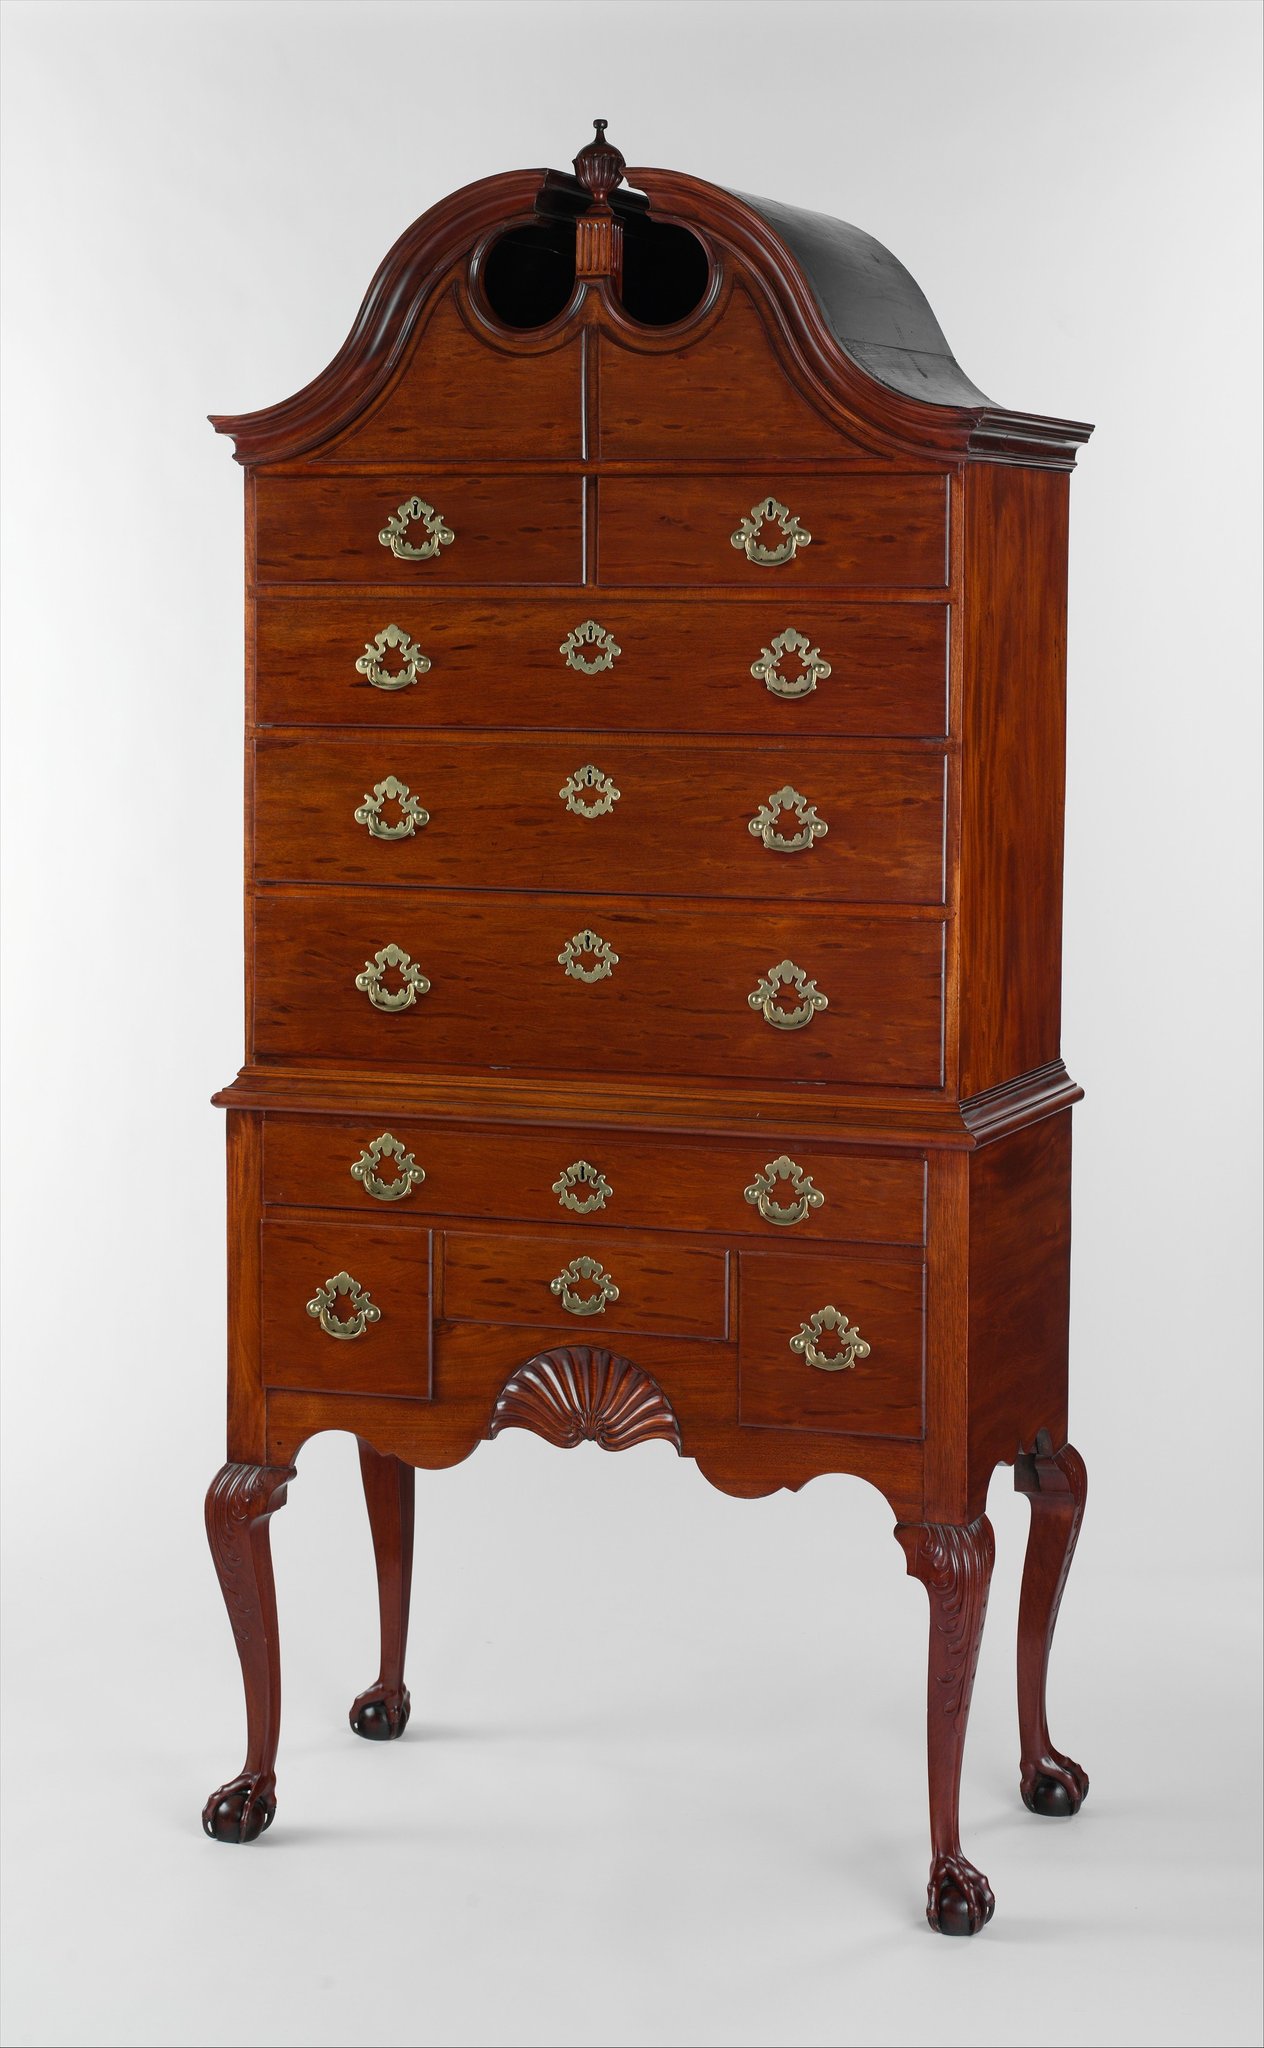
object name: high chest of drawer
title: High Chest of Drawers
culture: american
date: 1750-1790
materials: wood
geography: united states